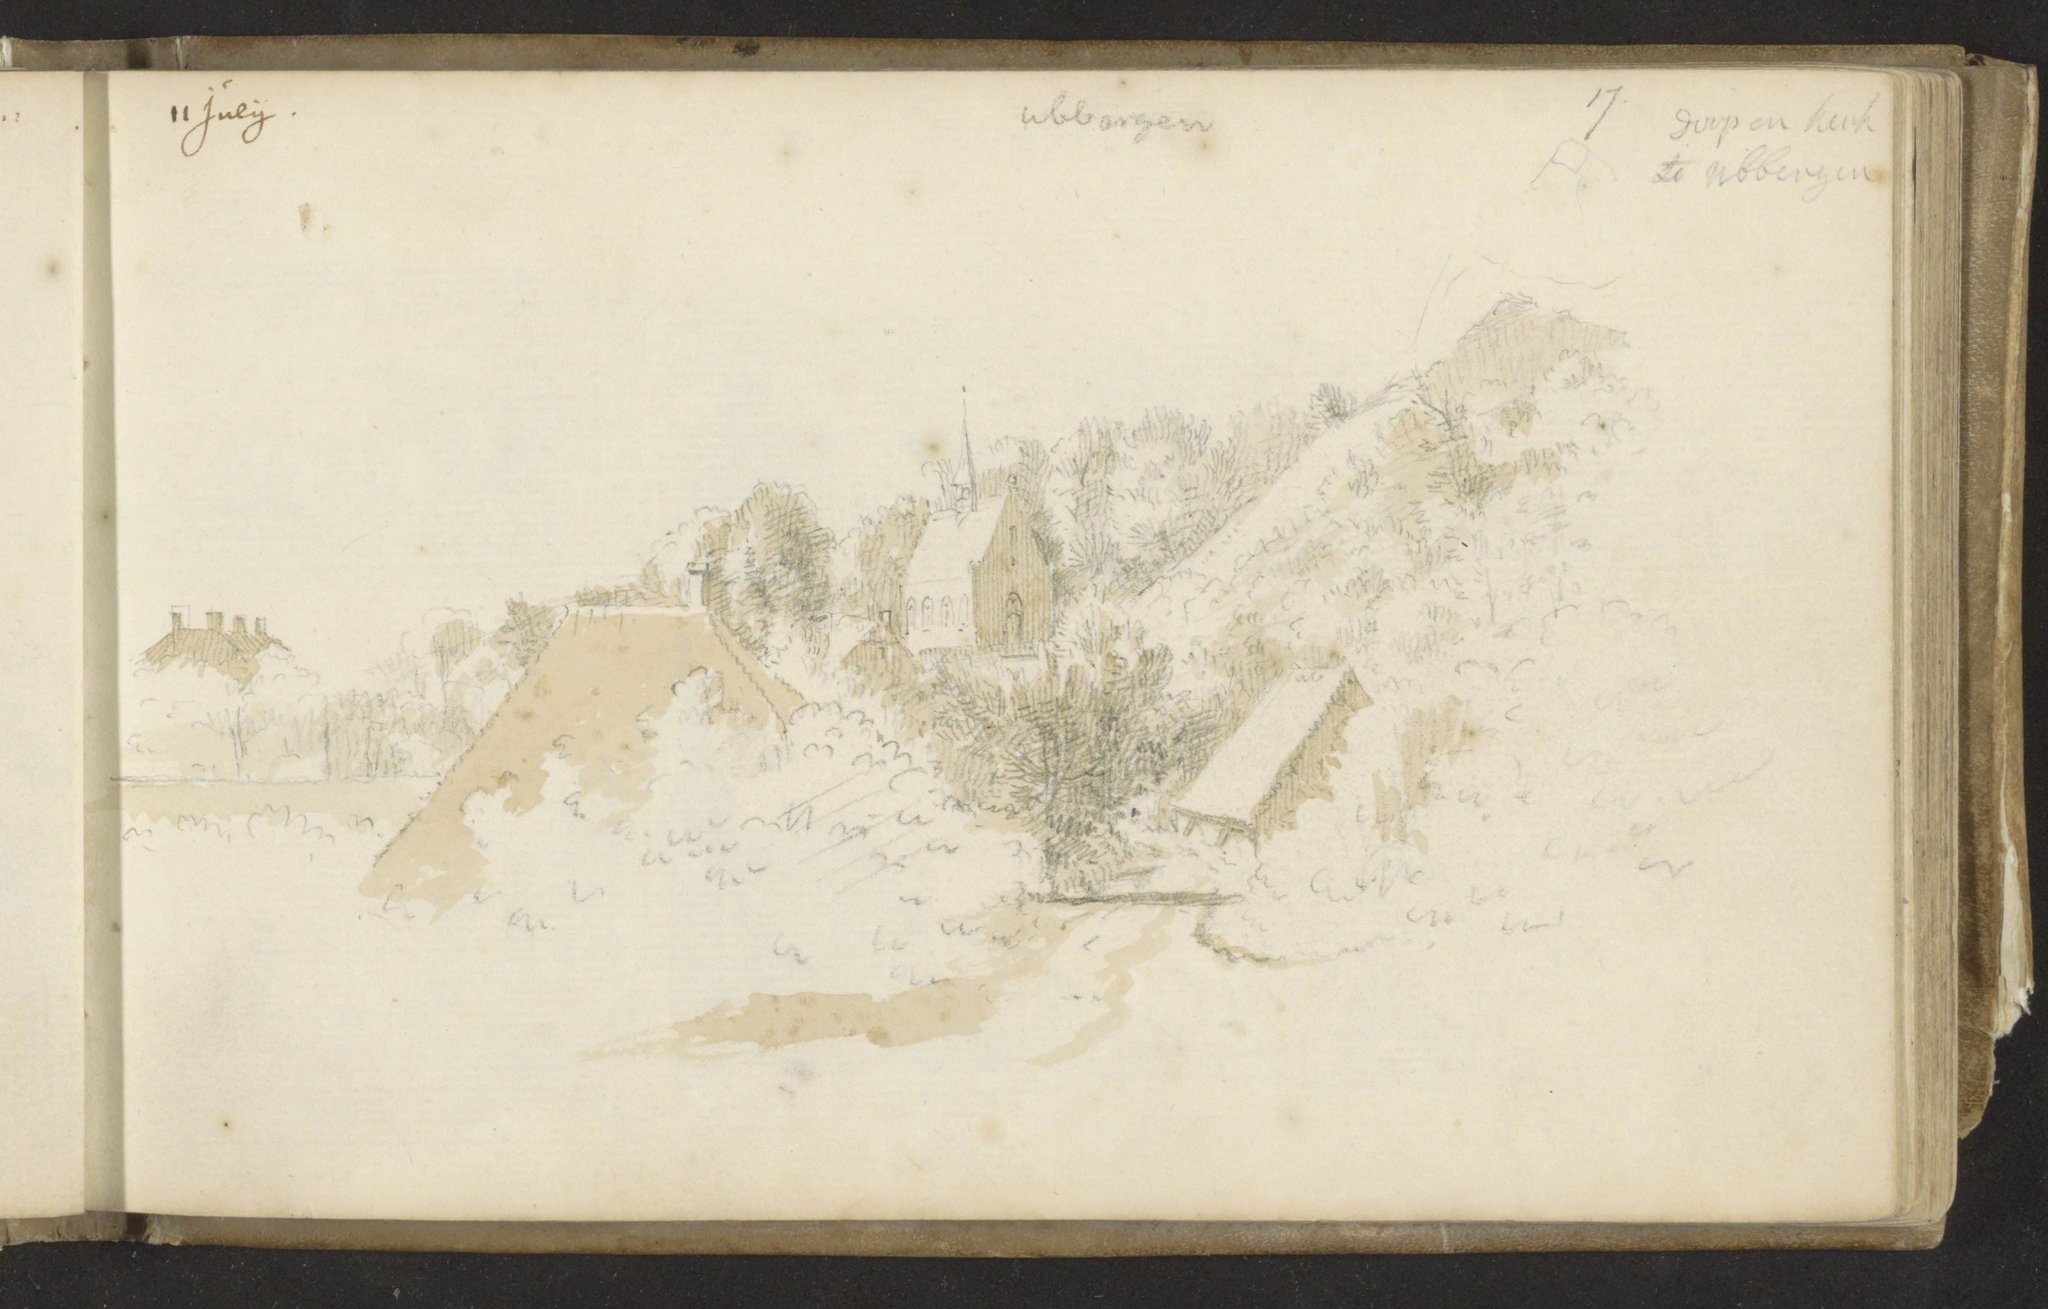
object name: sketchbook leaf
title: Dorpsgezicht te Ubbergen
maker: abraham de haen (ii)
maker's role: draughtsman, print maker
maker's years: 1707-1748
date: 1731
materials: ink, paper, pencil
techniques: brush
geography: ubbergen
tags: prospect of village, silhouette of village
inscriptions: date and inscription: ‘11 julij/ ubbergen/ dorp en kerk/ te Ubbergen’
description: Blad 17 recto uit een schetsboek met 69 bladen.